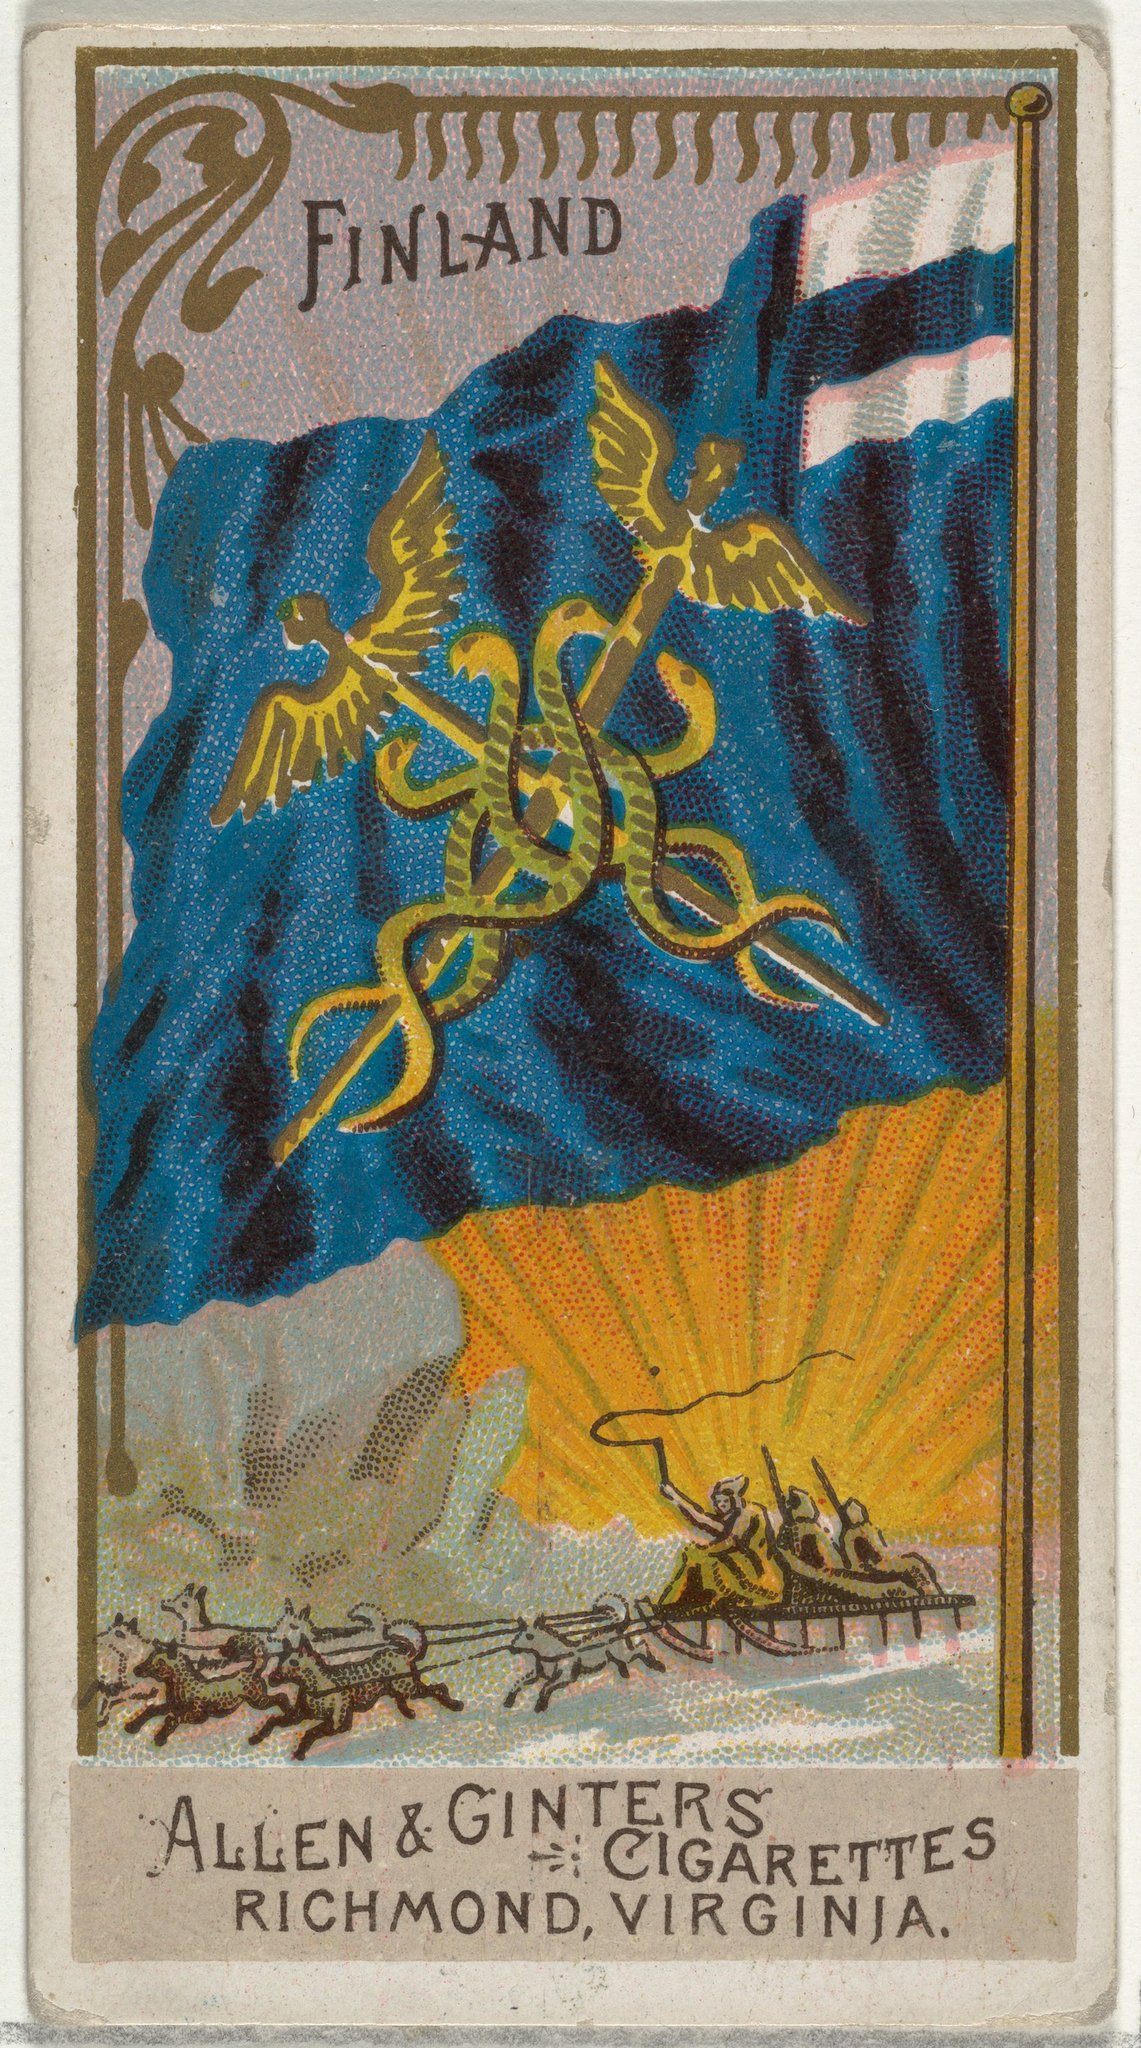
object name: print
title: Finland, from Flags of All Nations, Series 2 (N10) for Allen & Ginter Cigarettes Brands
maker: allen & ginter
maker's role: publisher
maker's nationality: american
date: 1890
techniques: color lithograph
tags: flags